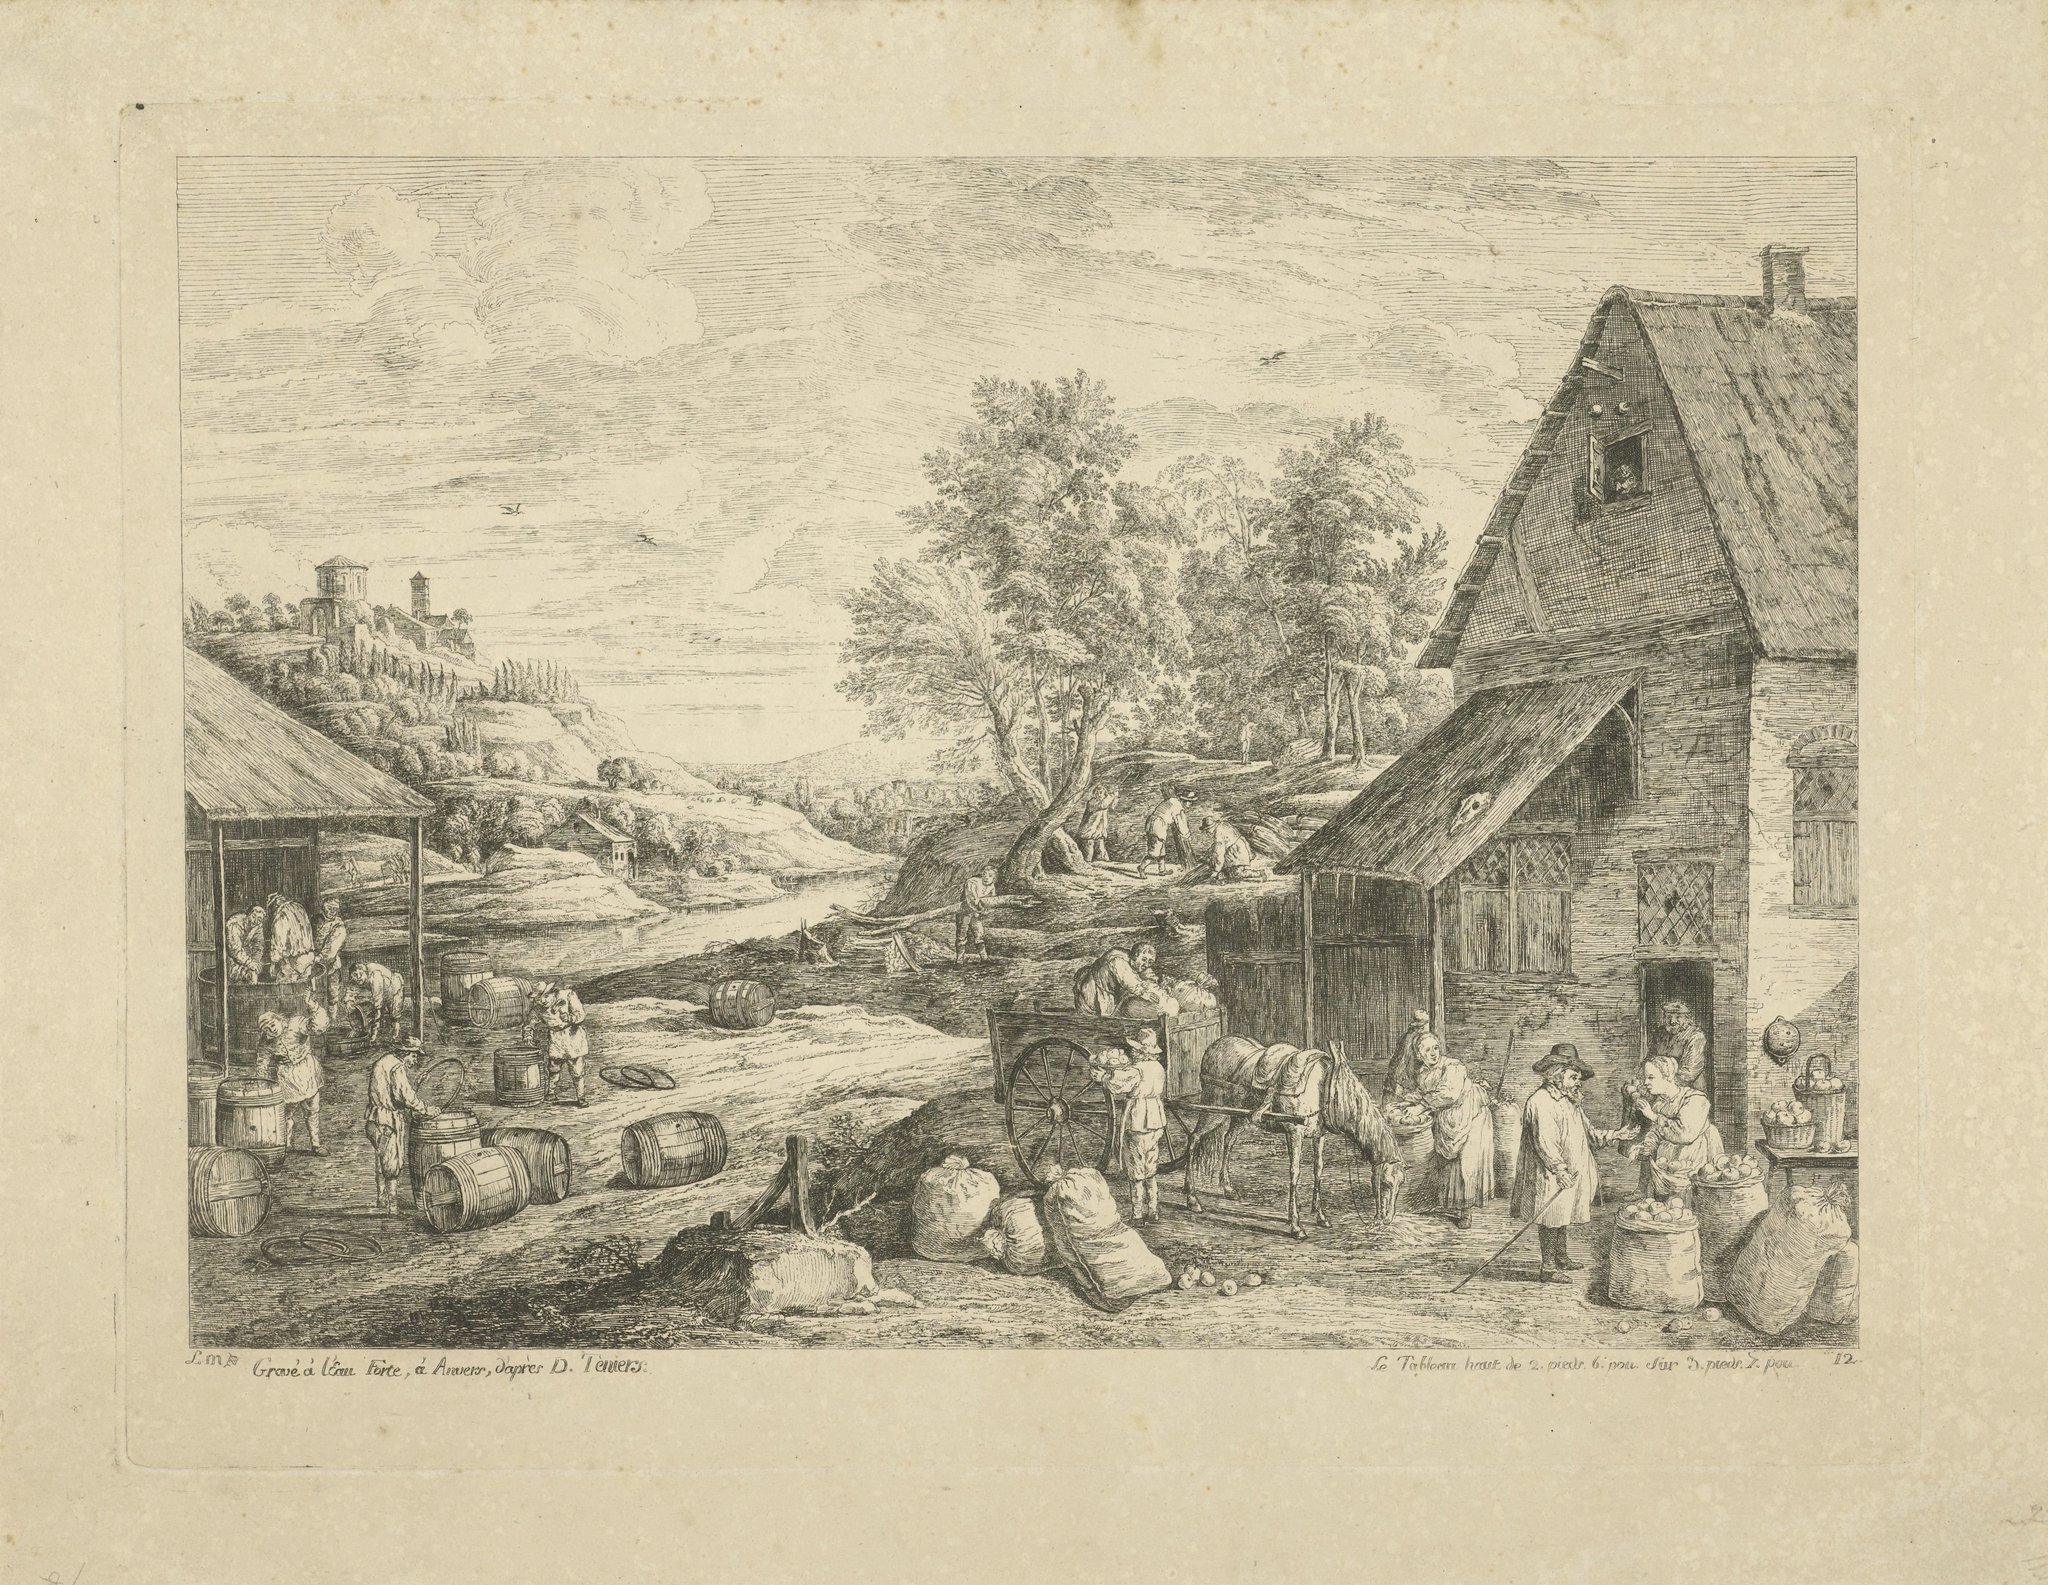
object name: print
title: Rivierlandschap met tonnenmakerij en appelverkoop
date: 1720-1820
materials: paper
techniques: etching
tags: wooden container: barrel, cask, bucket, fruits: apple, woodcutting, woodcutter ~ forestry, landscapes with waters, waterscapes, seascapes (in the temperate zone)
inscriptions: collector's mark: Lugt 240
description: Rivierlandschap met links een tonnenmakerij, rechts worden appels verkocht. Op de achtergrond kappen figuren bomen om de tonnenmakerij van hout te voorzien.